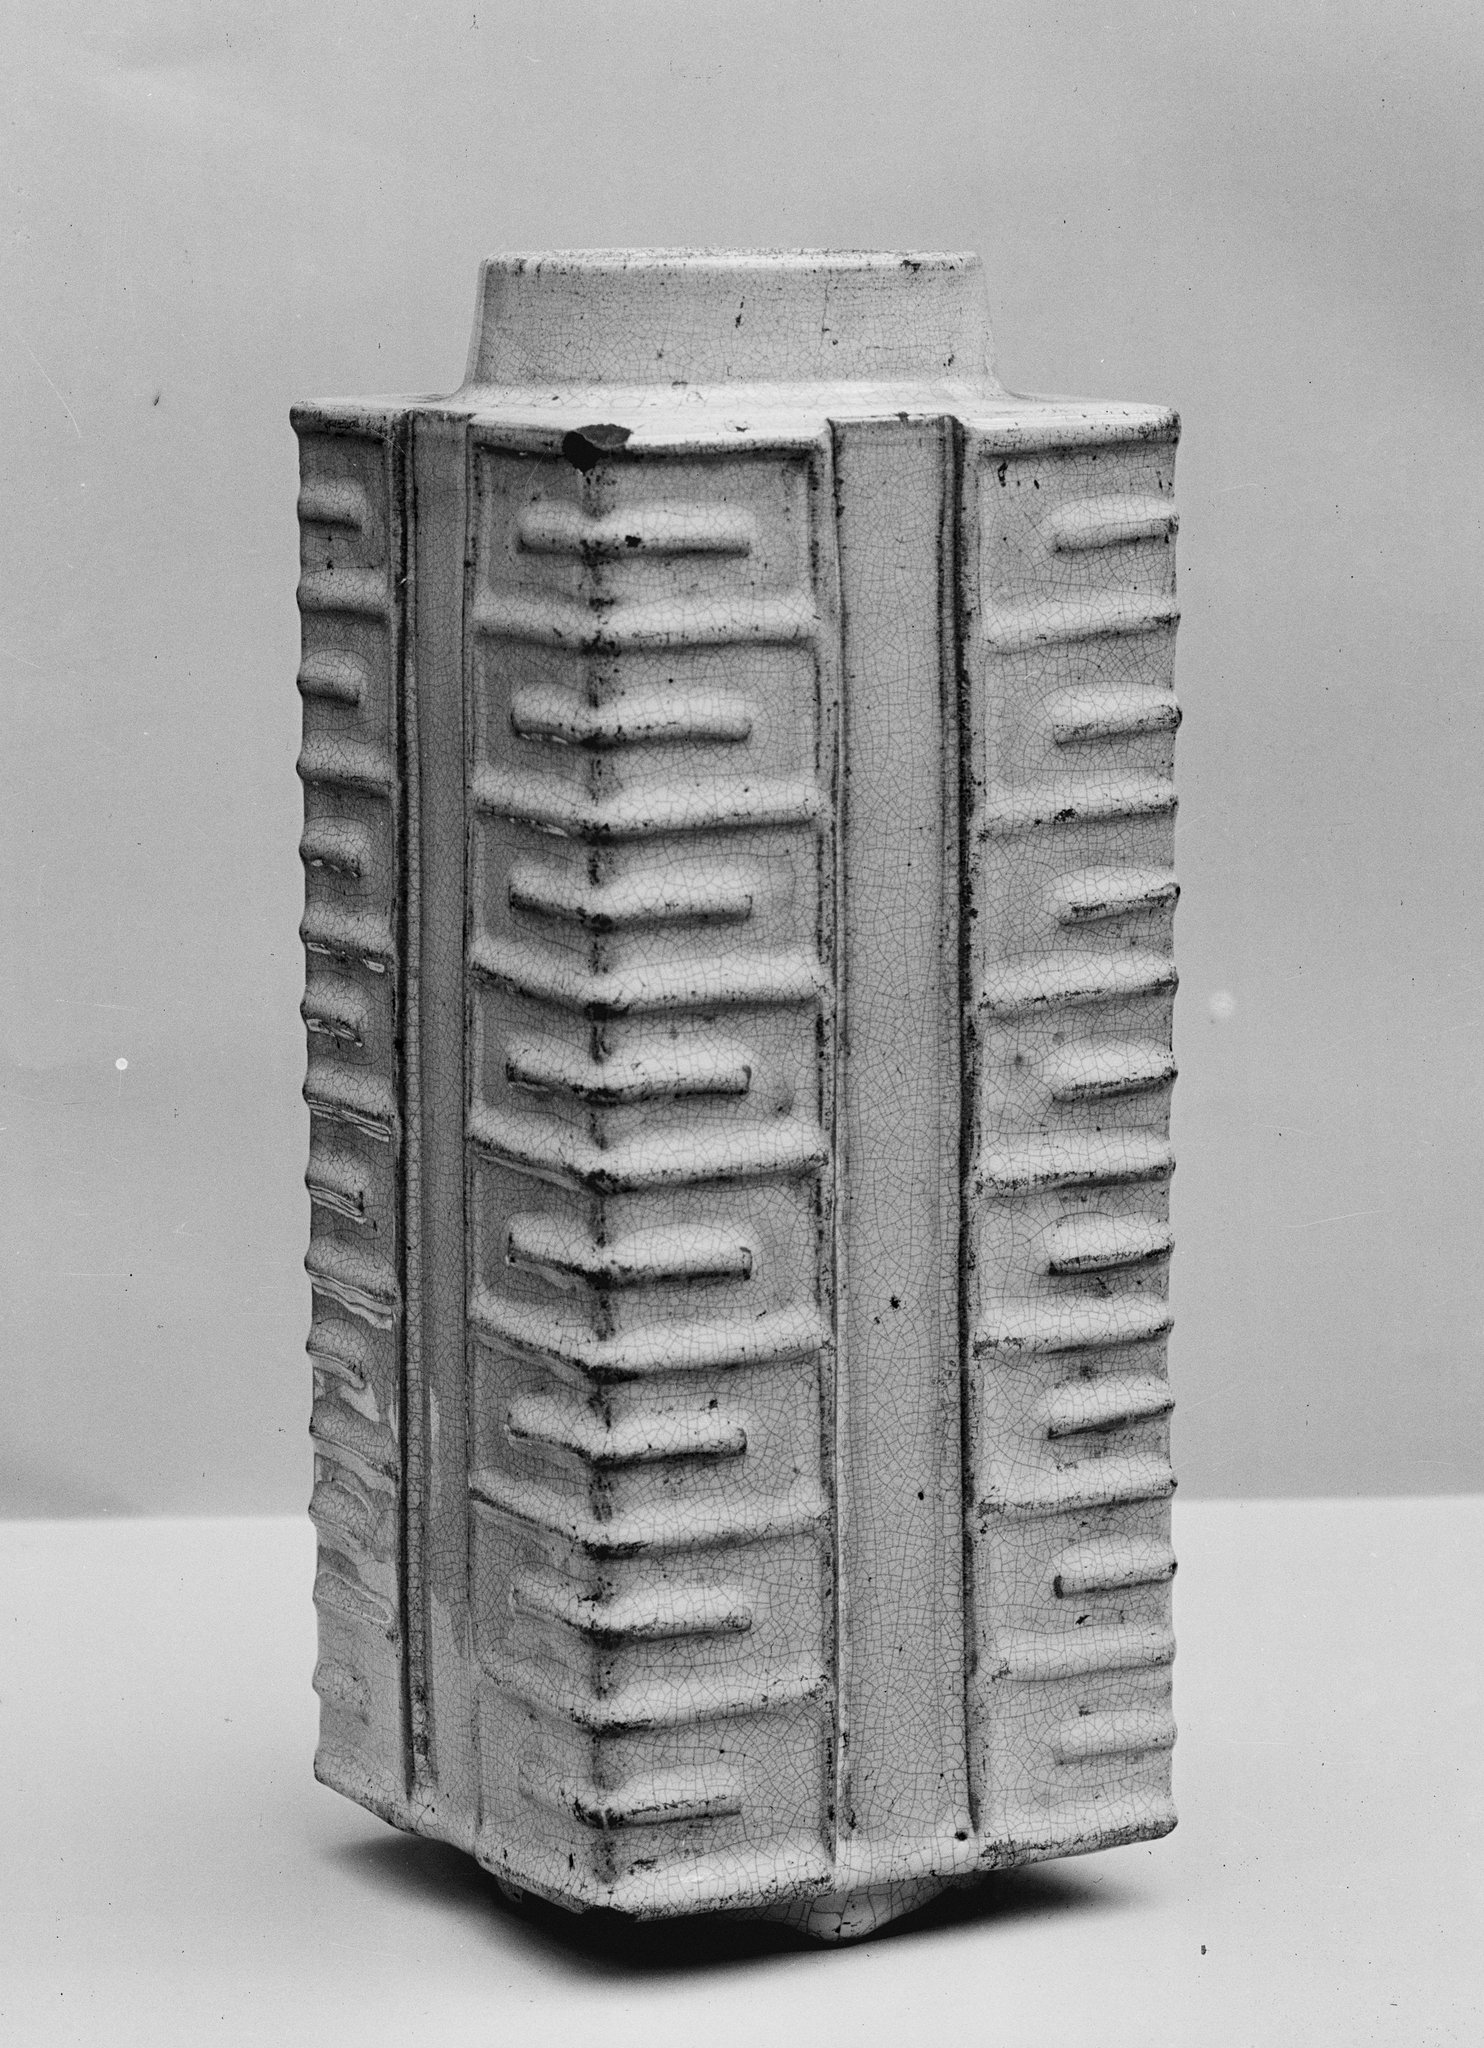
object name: vase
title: Quadrangular vase in the form of a Neolithic ritual jade object (Cong)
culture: chinese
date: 1801-1900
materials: glaze, stoneware